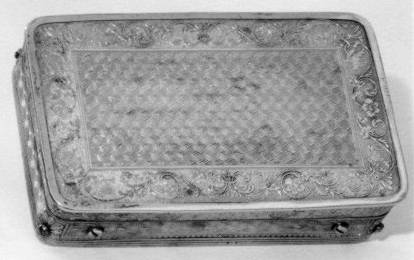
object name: music box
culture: swiss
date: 1810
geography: switzerland